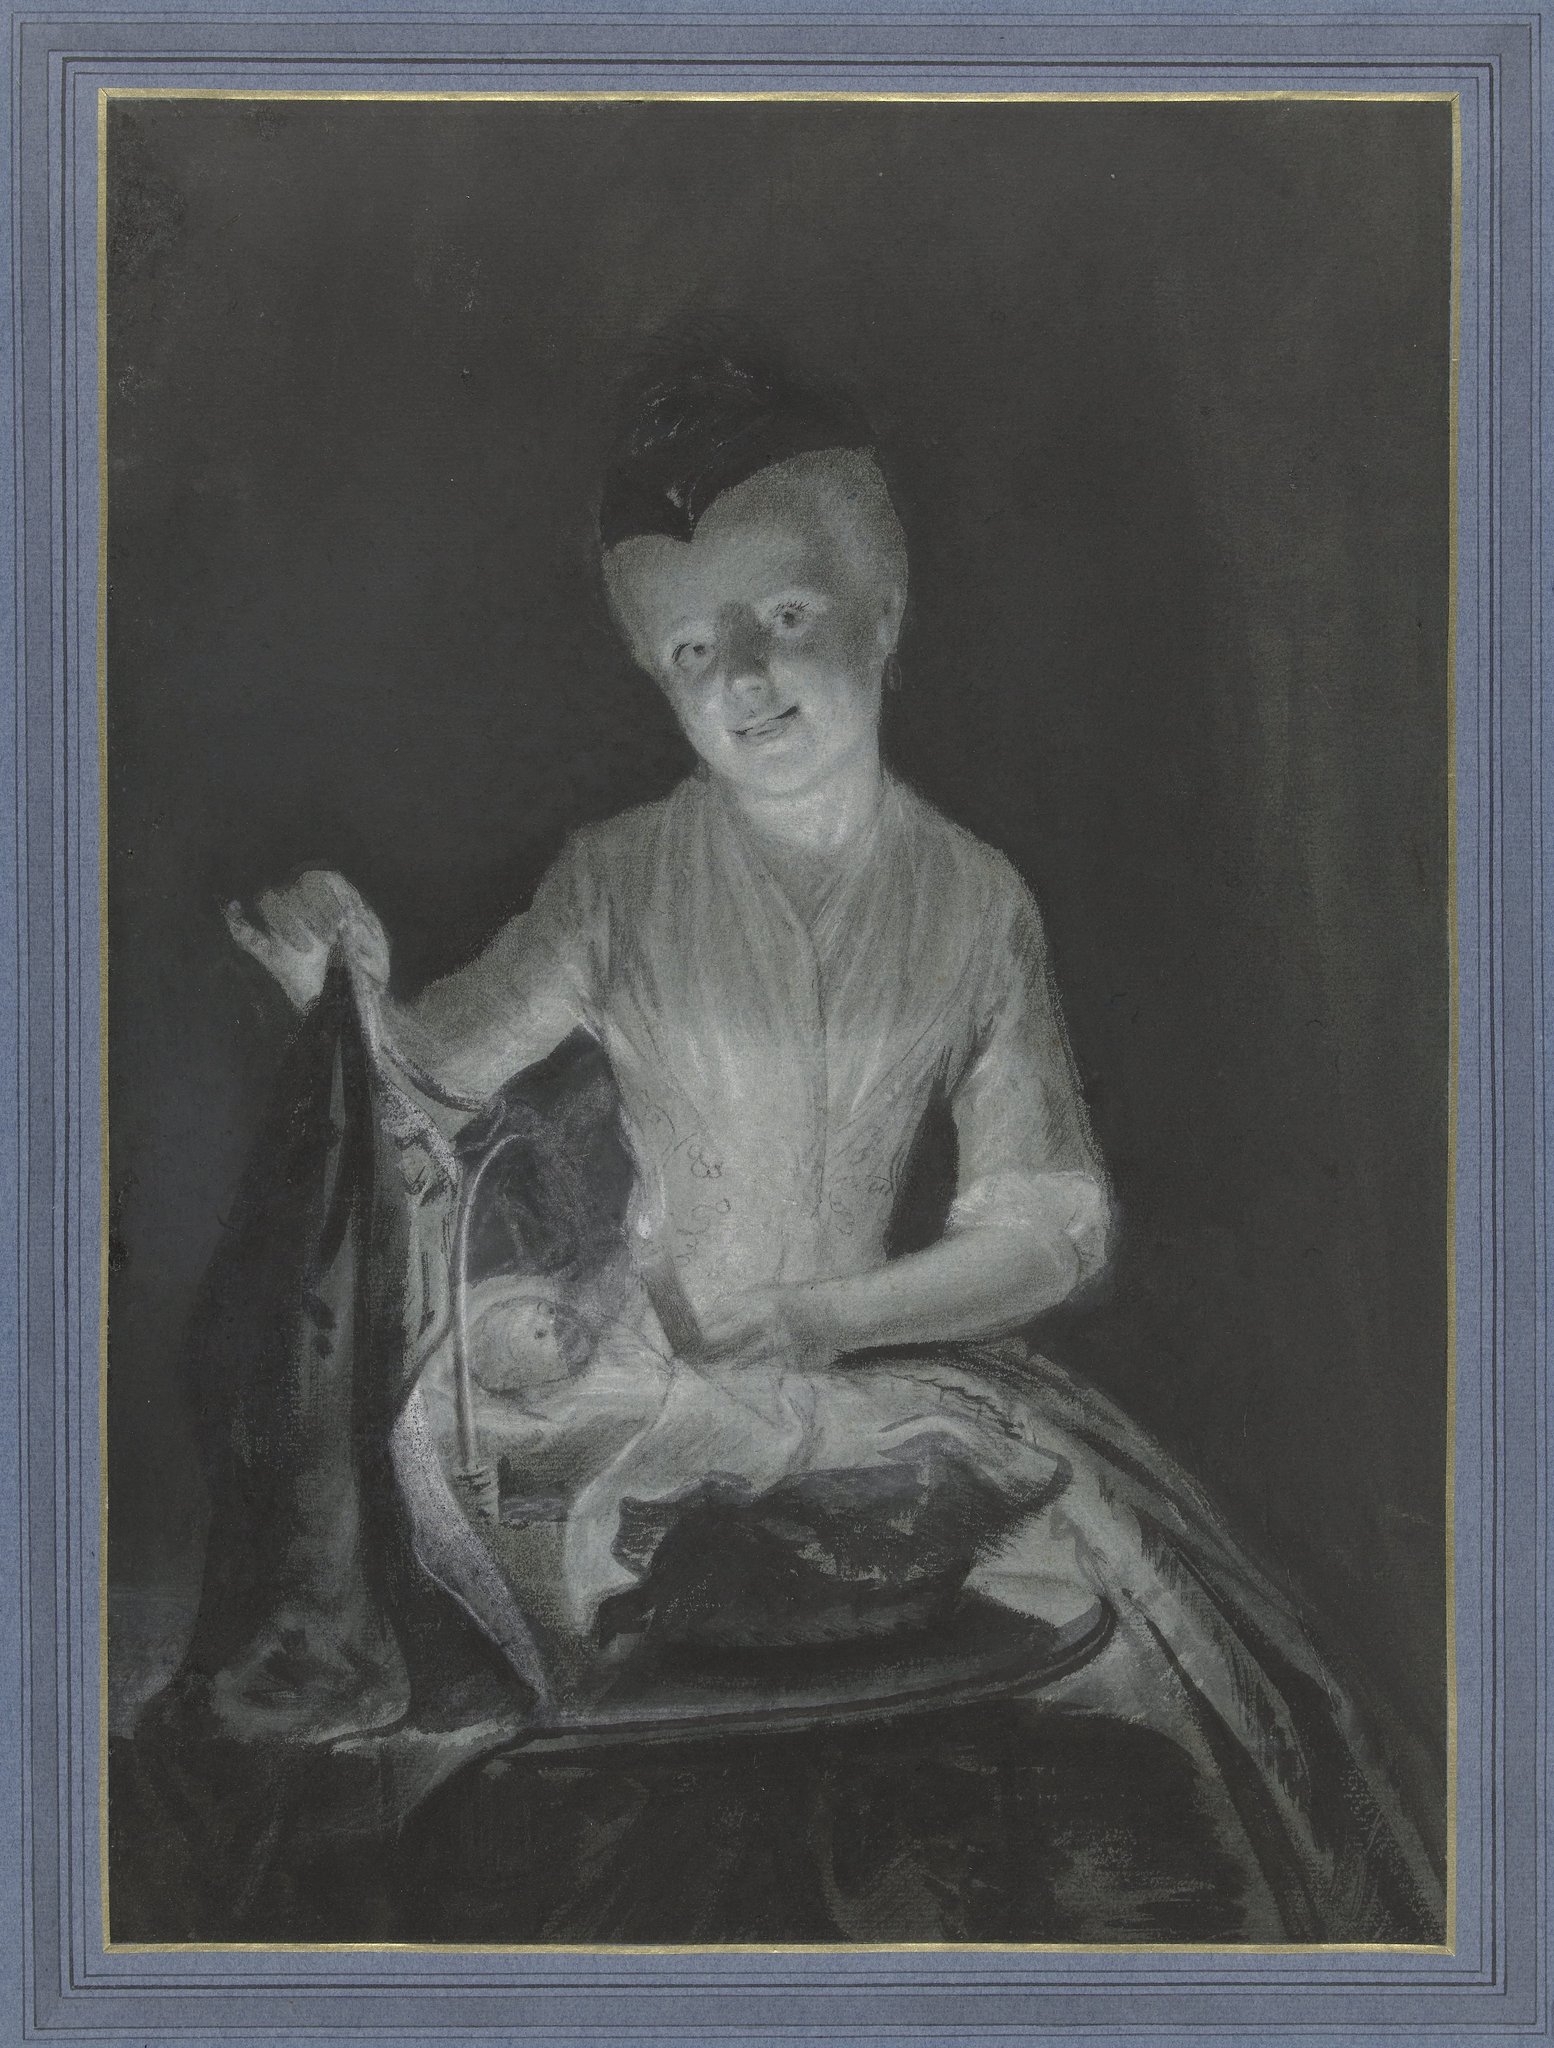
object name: drawing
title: Sara Troost met haar pop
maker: cornelis troost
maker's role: draughtsman, painter, print maker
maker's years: 1696-1750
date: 1740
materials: chalk, paper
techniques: brush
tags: sara troost, historical persons - bb - woman, (playing with) dolls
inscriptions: inscription: ‘Sara Troost met haar pop / door C. Troost 1740’